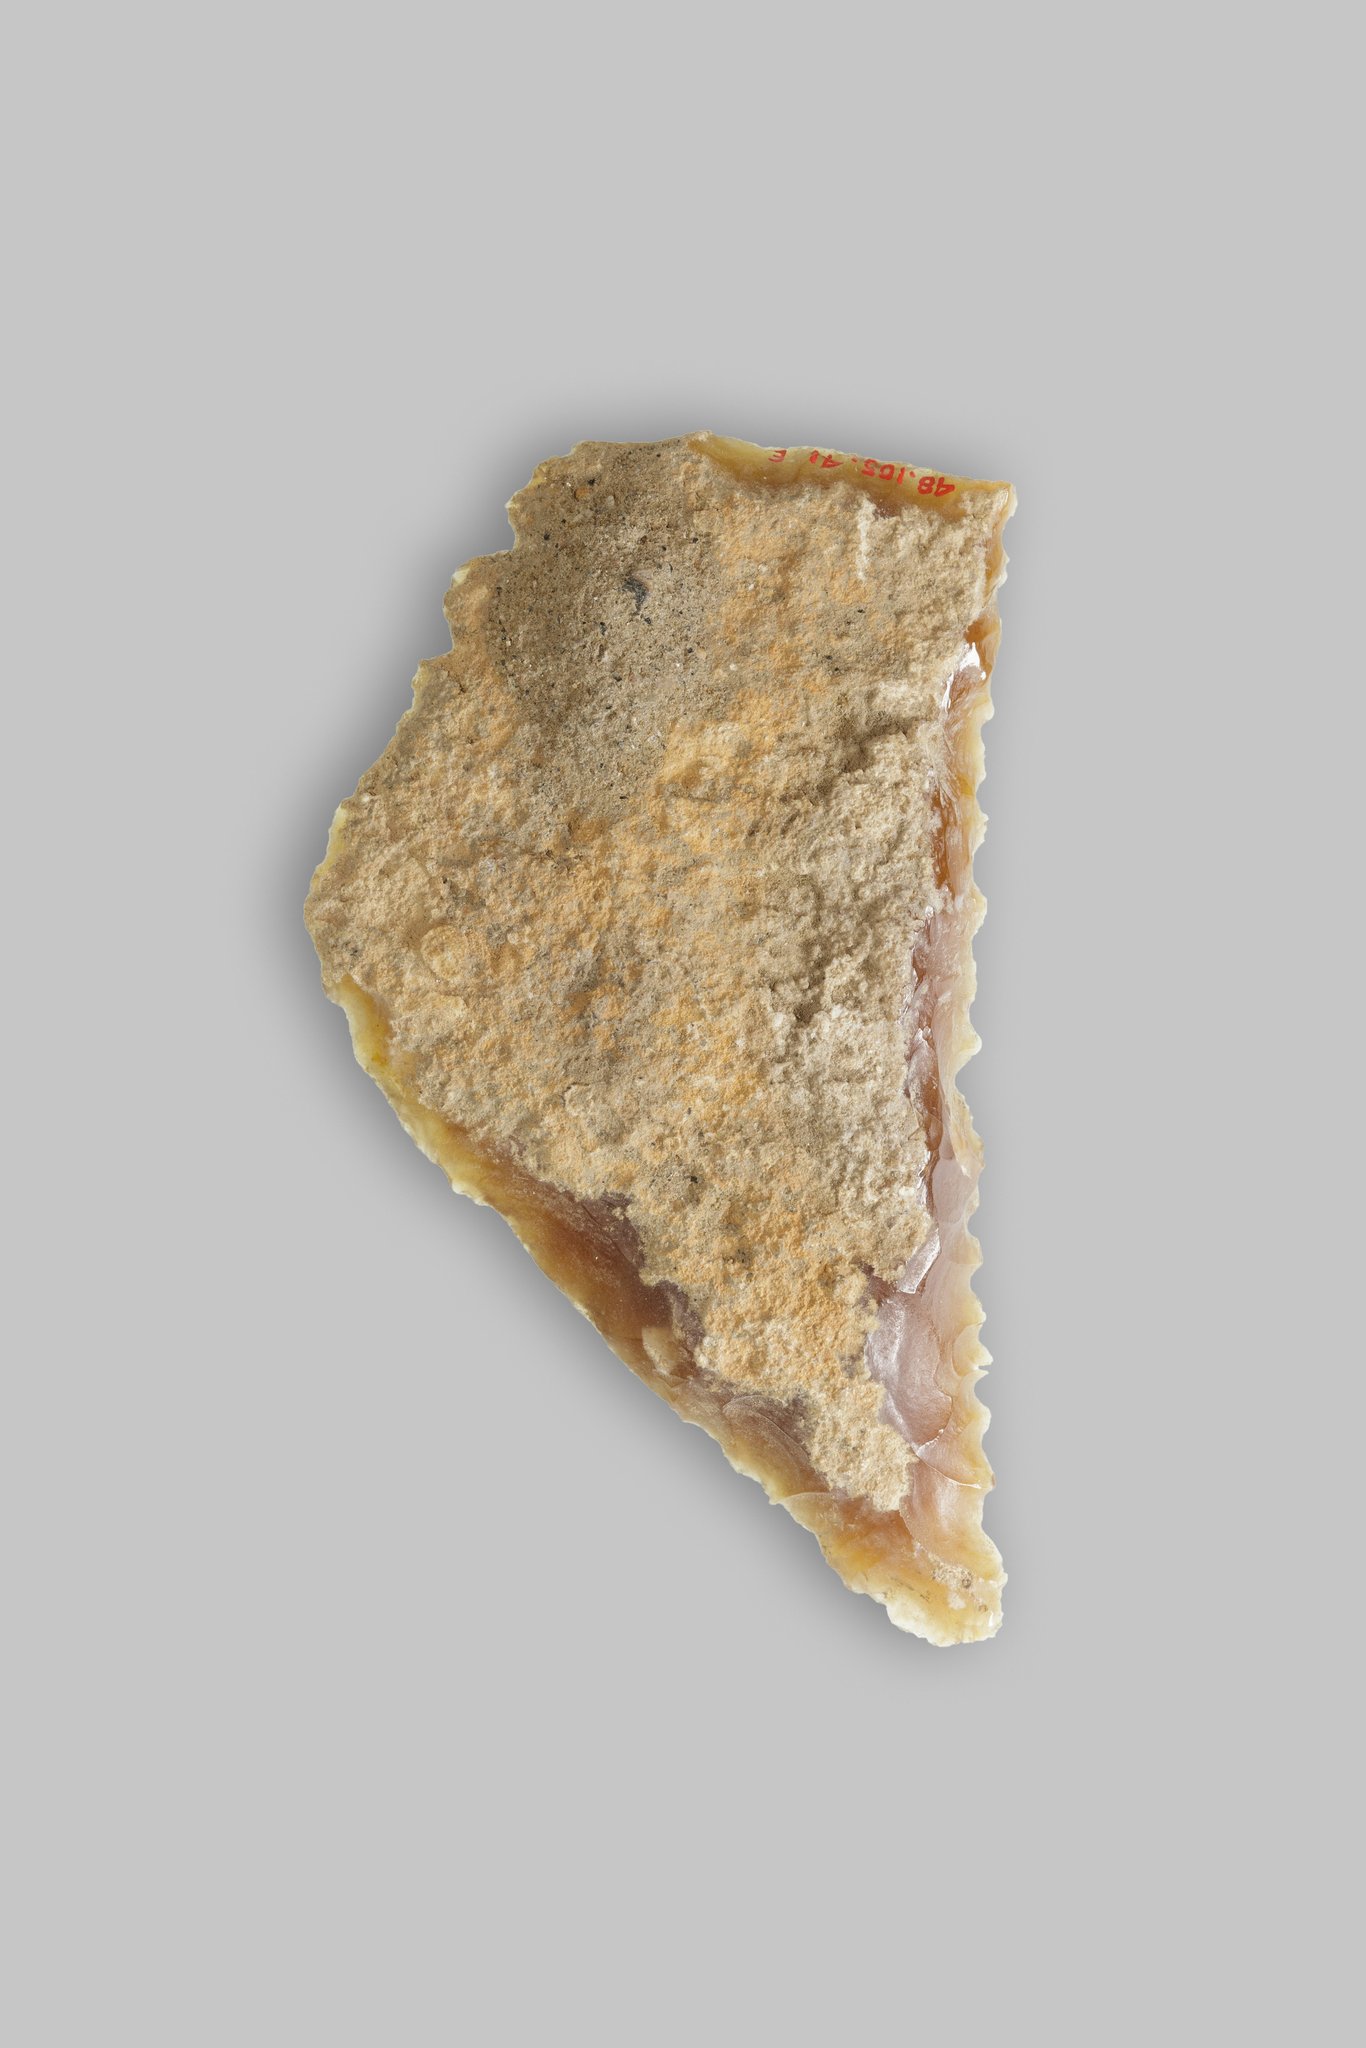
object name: sickle, denticulate, truncated, backed, geometric, tool, element, adhesive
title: Sickle Insert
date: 1184-664 BCE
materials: stone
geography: egypt